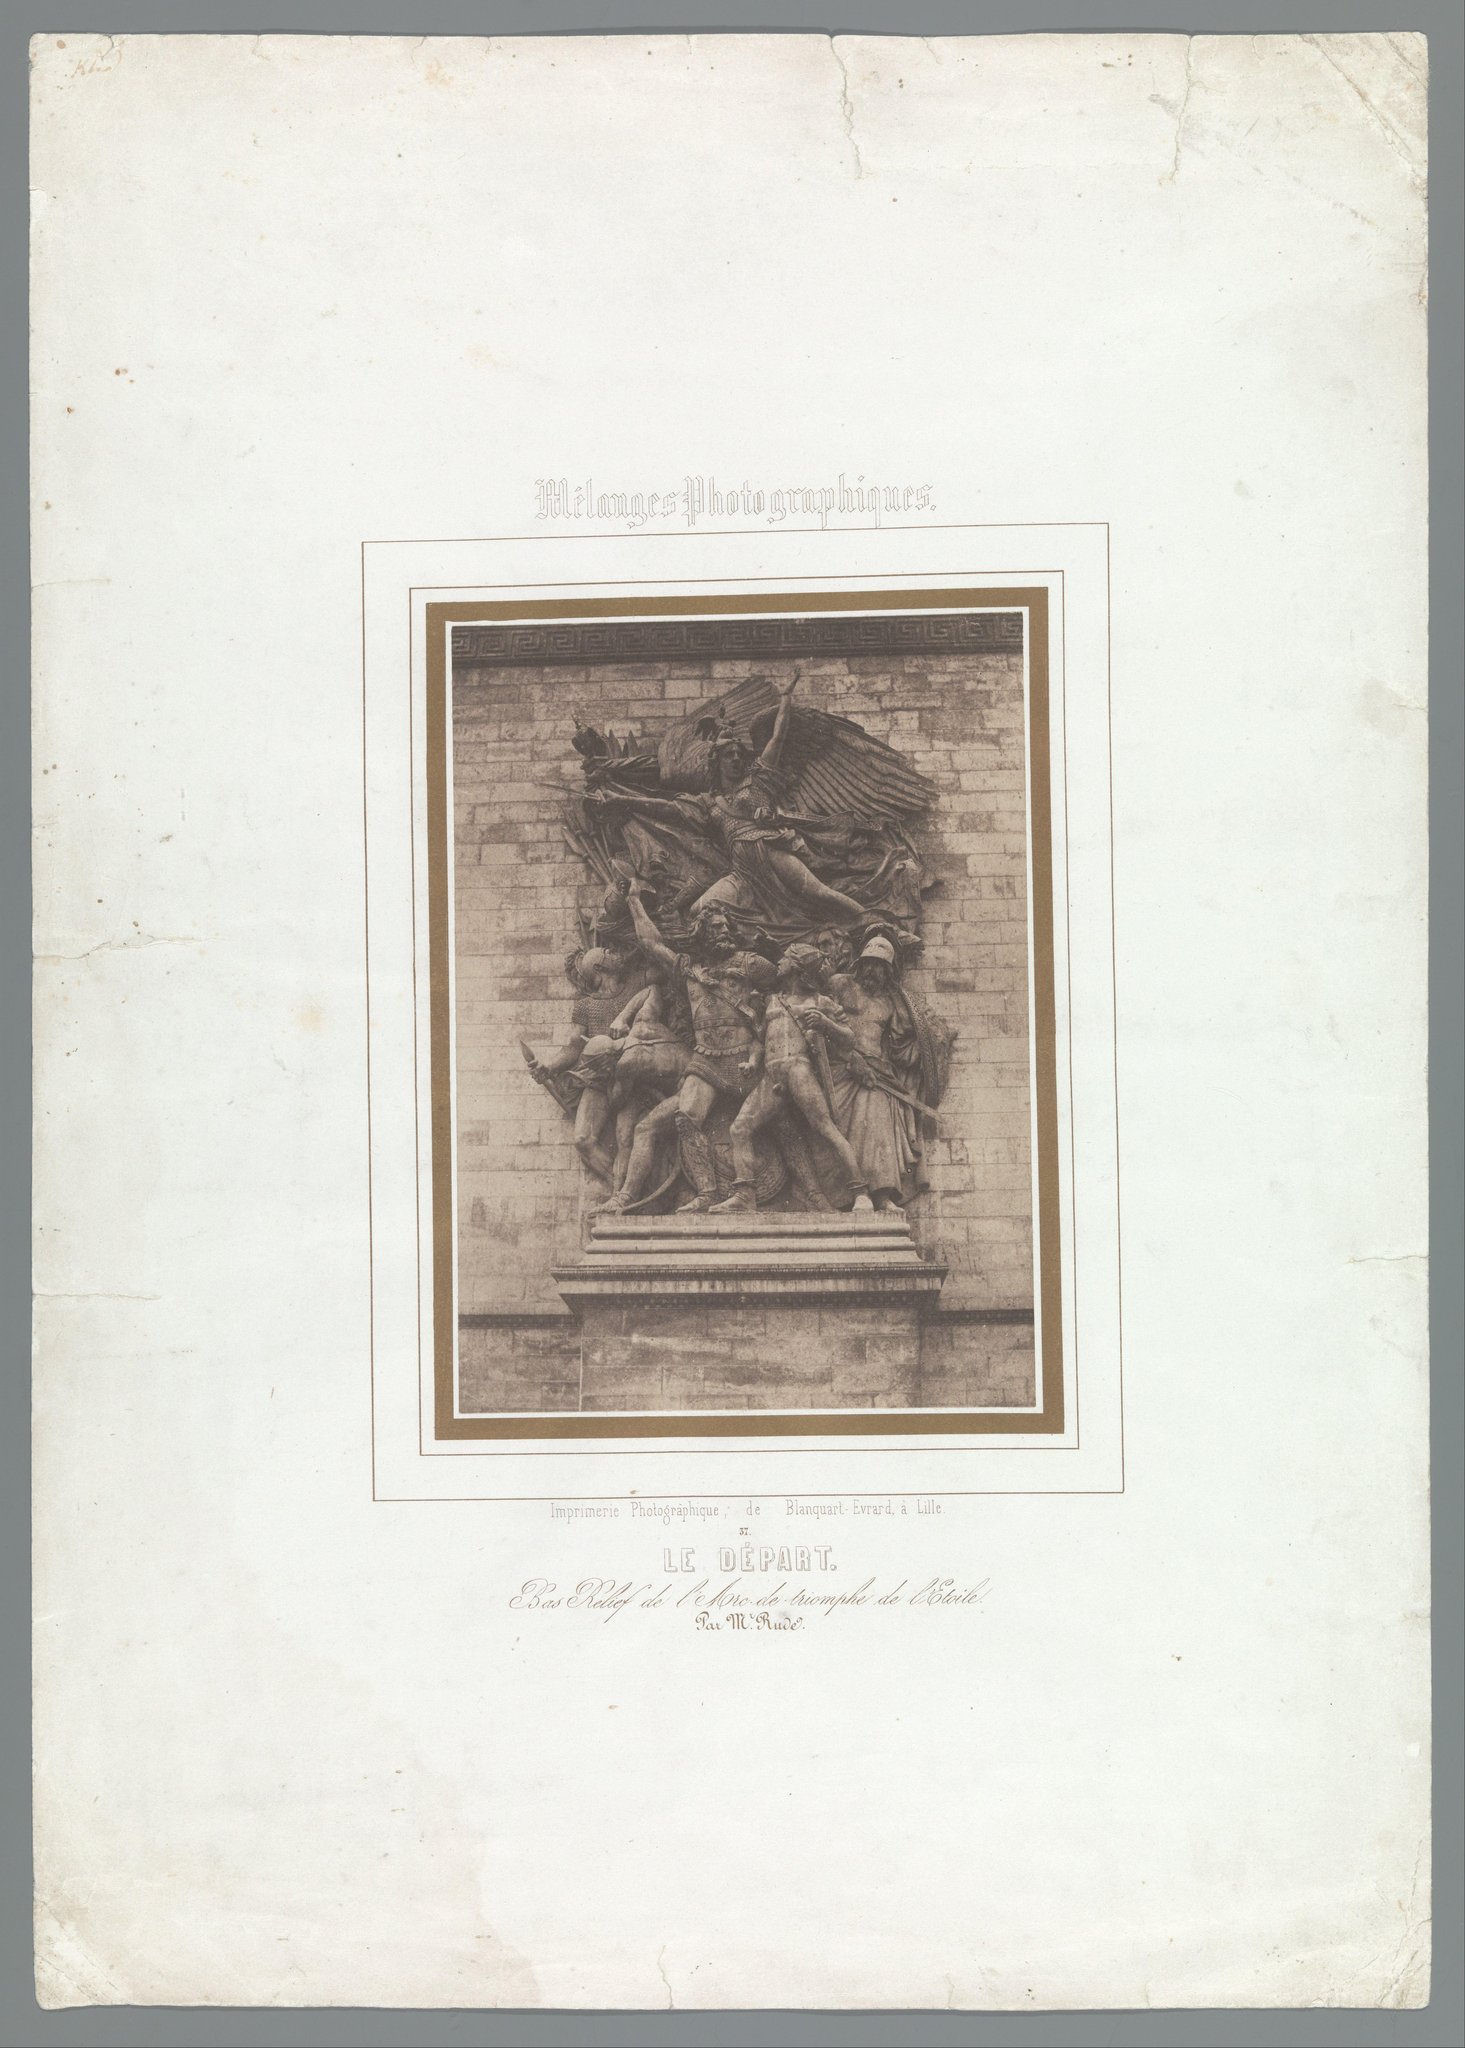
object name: photograph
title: Mélanges Photographiques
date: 1851-1853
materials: cardboard, photographic support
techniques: salted paper print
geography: paris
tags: piece of sculpture, reproduction of a piece of sculpture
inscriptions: inscription: ‘planch 3+ p 231/ repro 320/ Intrede Jannus) [?]/ des 1851/2/ atte à Marville/ IID’, number: ‘37.’, inscription: ‘Bas Relief de l'Arc de triomphe de l'Etoile./ Par M. Rude.’